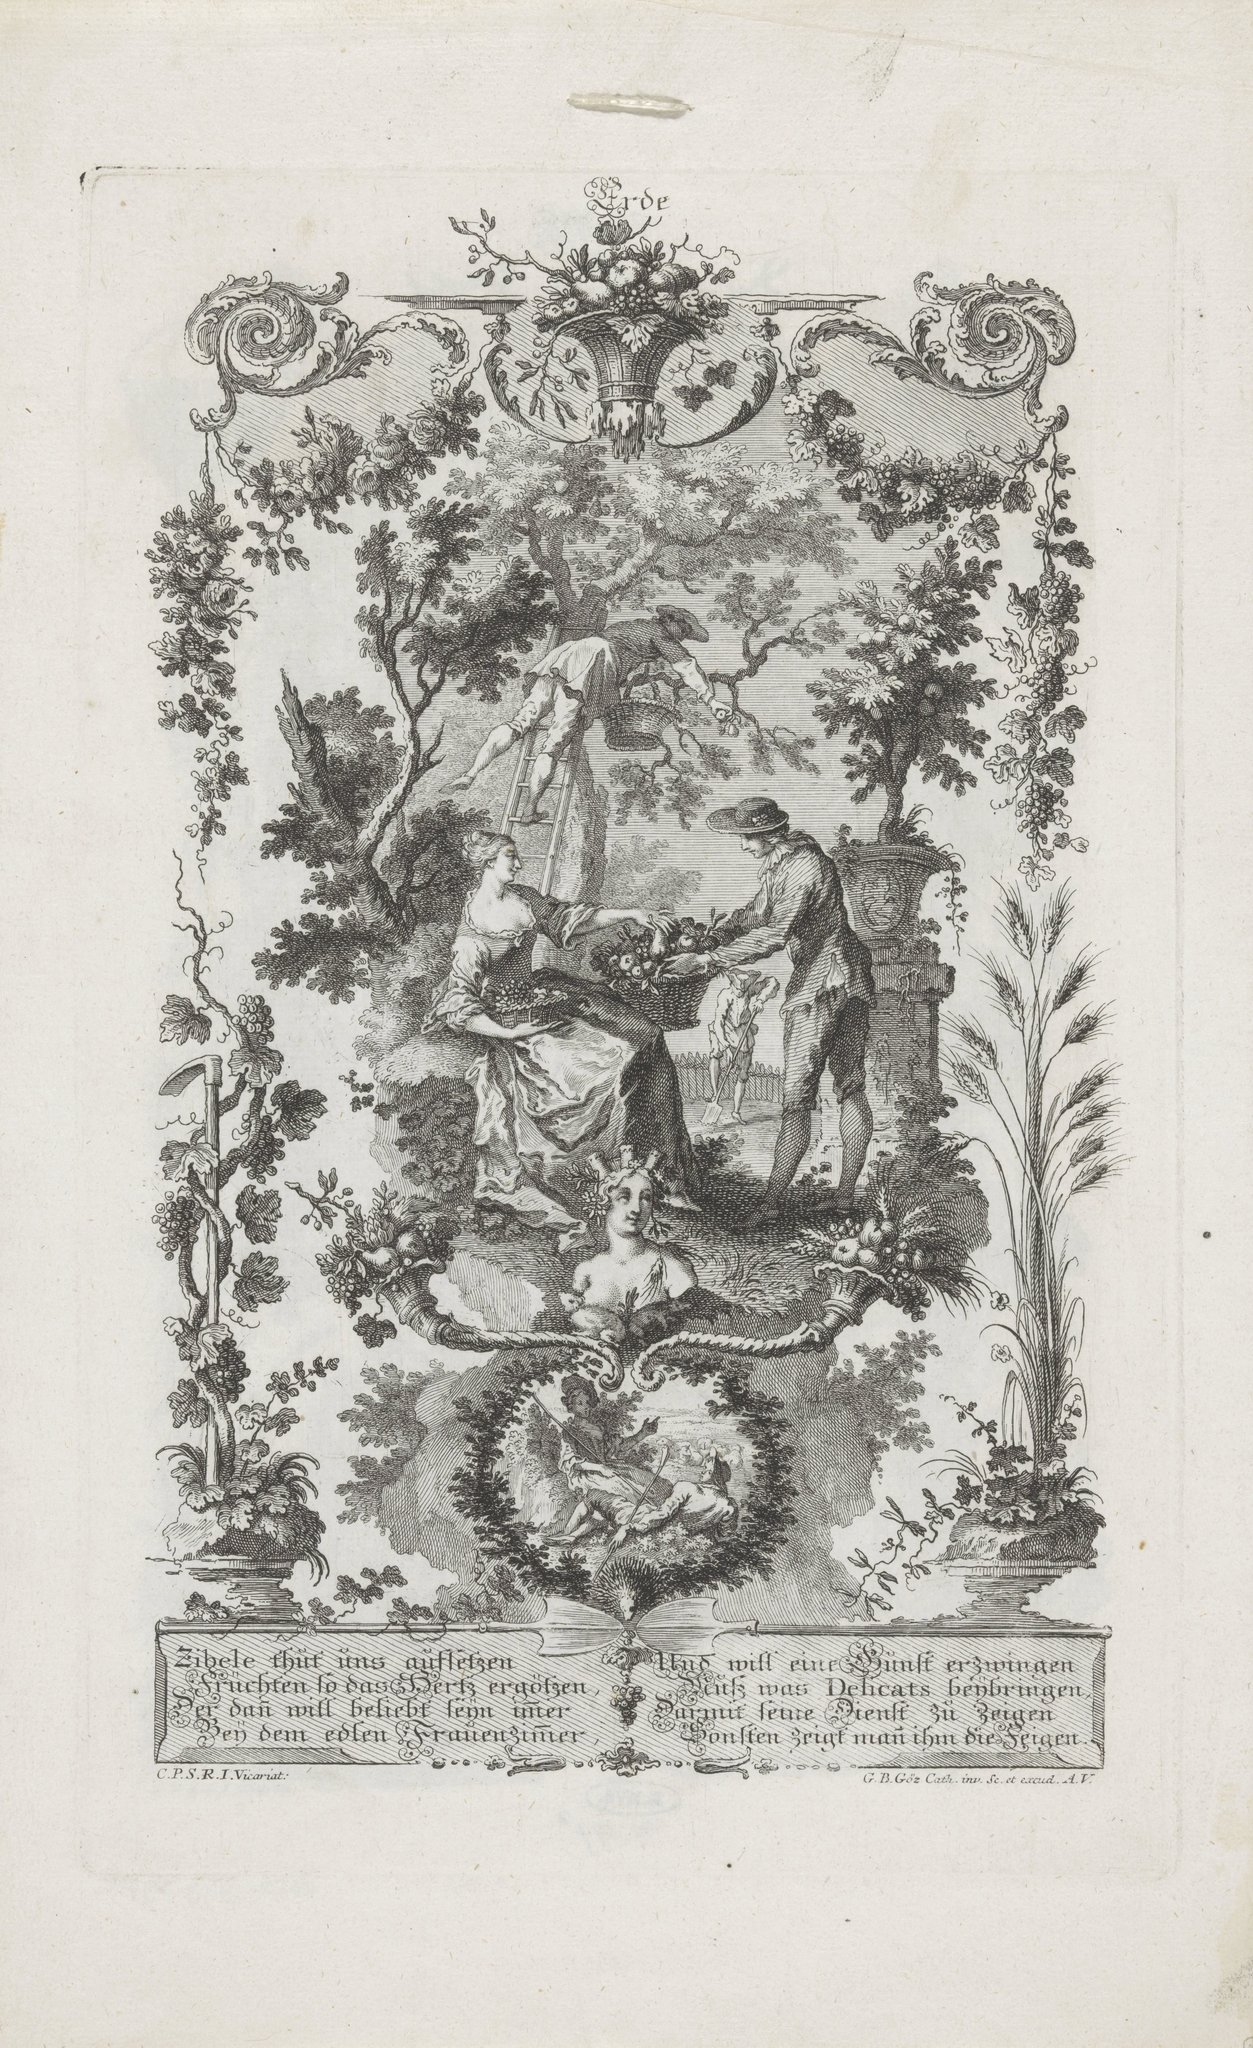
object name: print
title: Erde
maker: gottfried bernhard götz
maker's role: artist, draughtsman, painter, print maker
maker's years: 1708-1774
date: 1718-1774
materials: paper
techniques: etching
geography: augsburg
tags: 'terra', 'carro della terra' (ripa), pastorals, arcadian scenes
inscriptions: collector's mark: Lugt 2228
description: Allegorie van het element aarde. Pastorale scène van mensen die fruit plukken en de aarde bewerken. Druivenranken en bloemmotieven omlijsten de scène. In de ondermarge een vierregelige Duitse tekst.